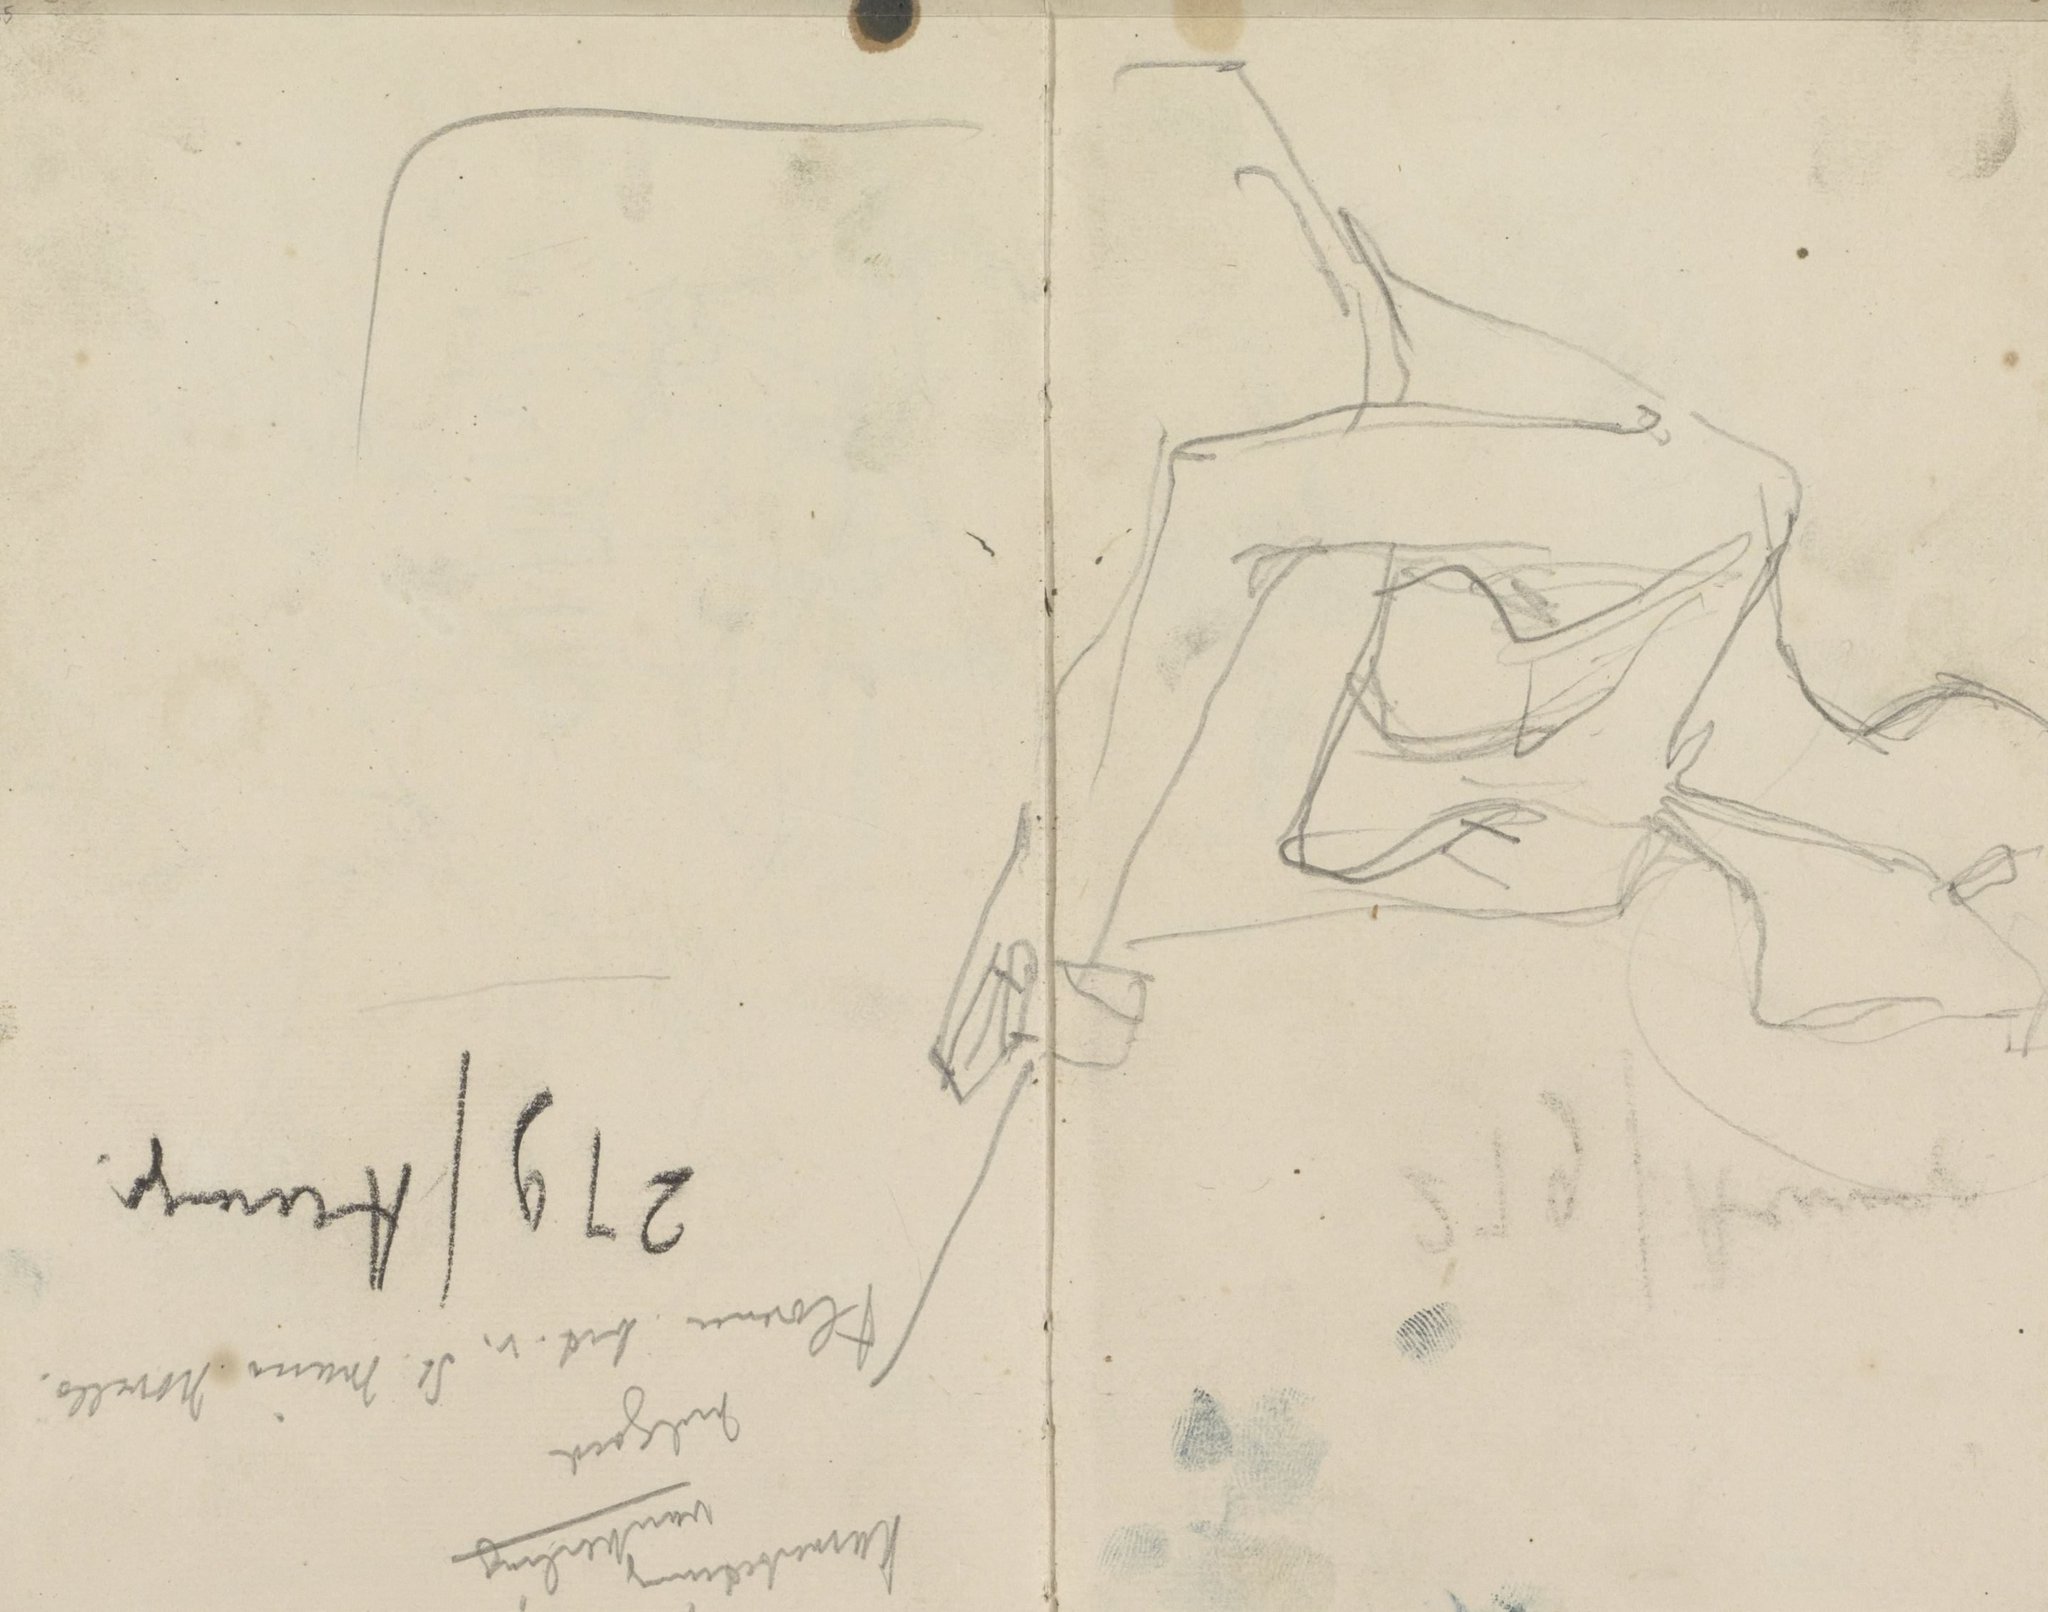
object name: sketchbook leaf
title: Vrouw, mogelijk zittend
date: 1881-1883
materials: paper, pencil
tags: adult woman, sitting figure - aa - female human figure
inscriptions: annotation: ‘Karnerbet[...]/ van Kerling/ [...]/ Florence [...] v. St. Maria Novello [sic]/ 279 Heerengr.’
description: Pagina 35 en pagina 36 uit een schetsboek met 19 bladen.